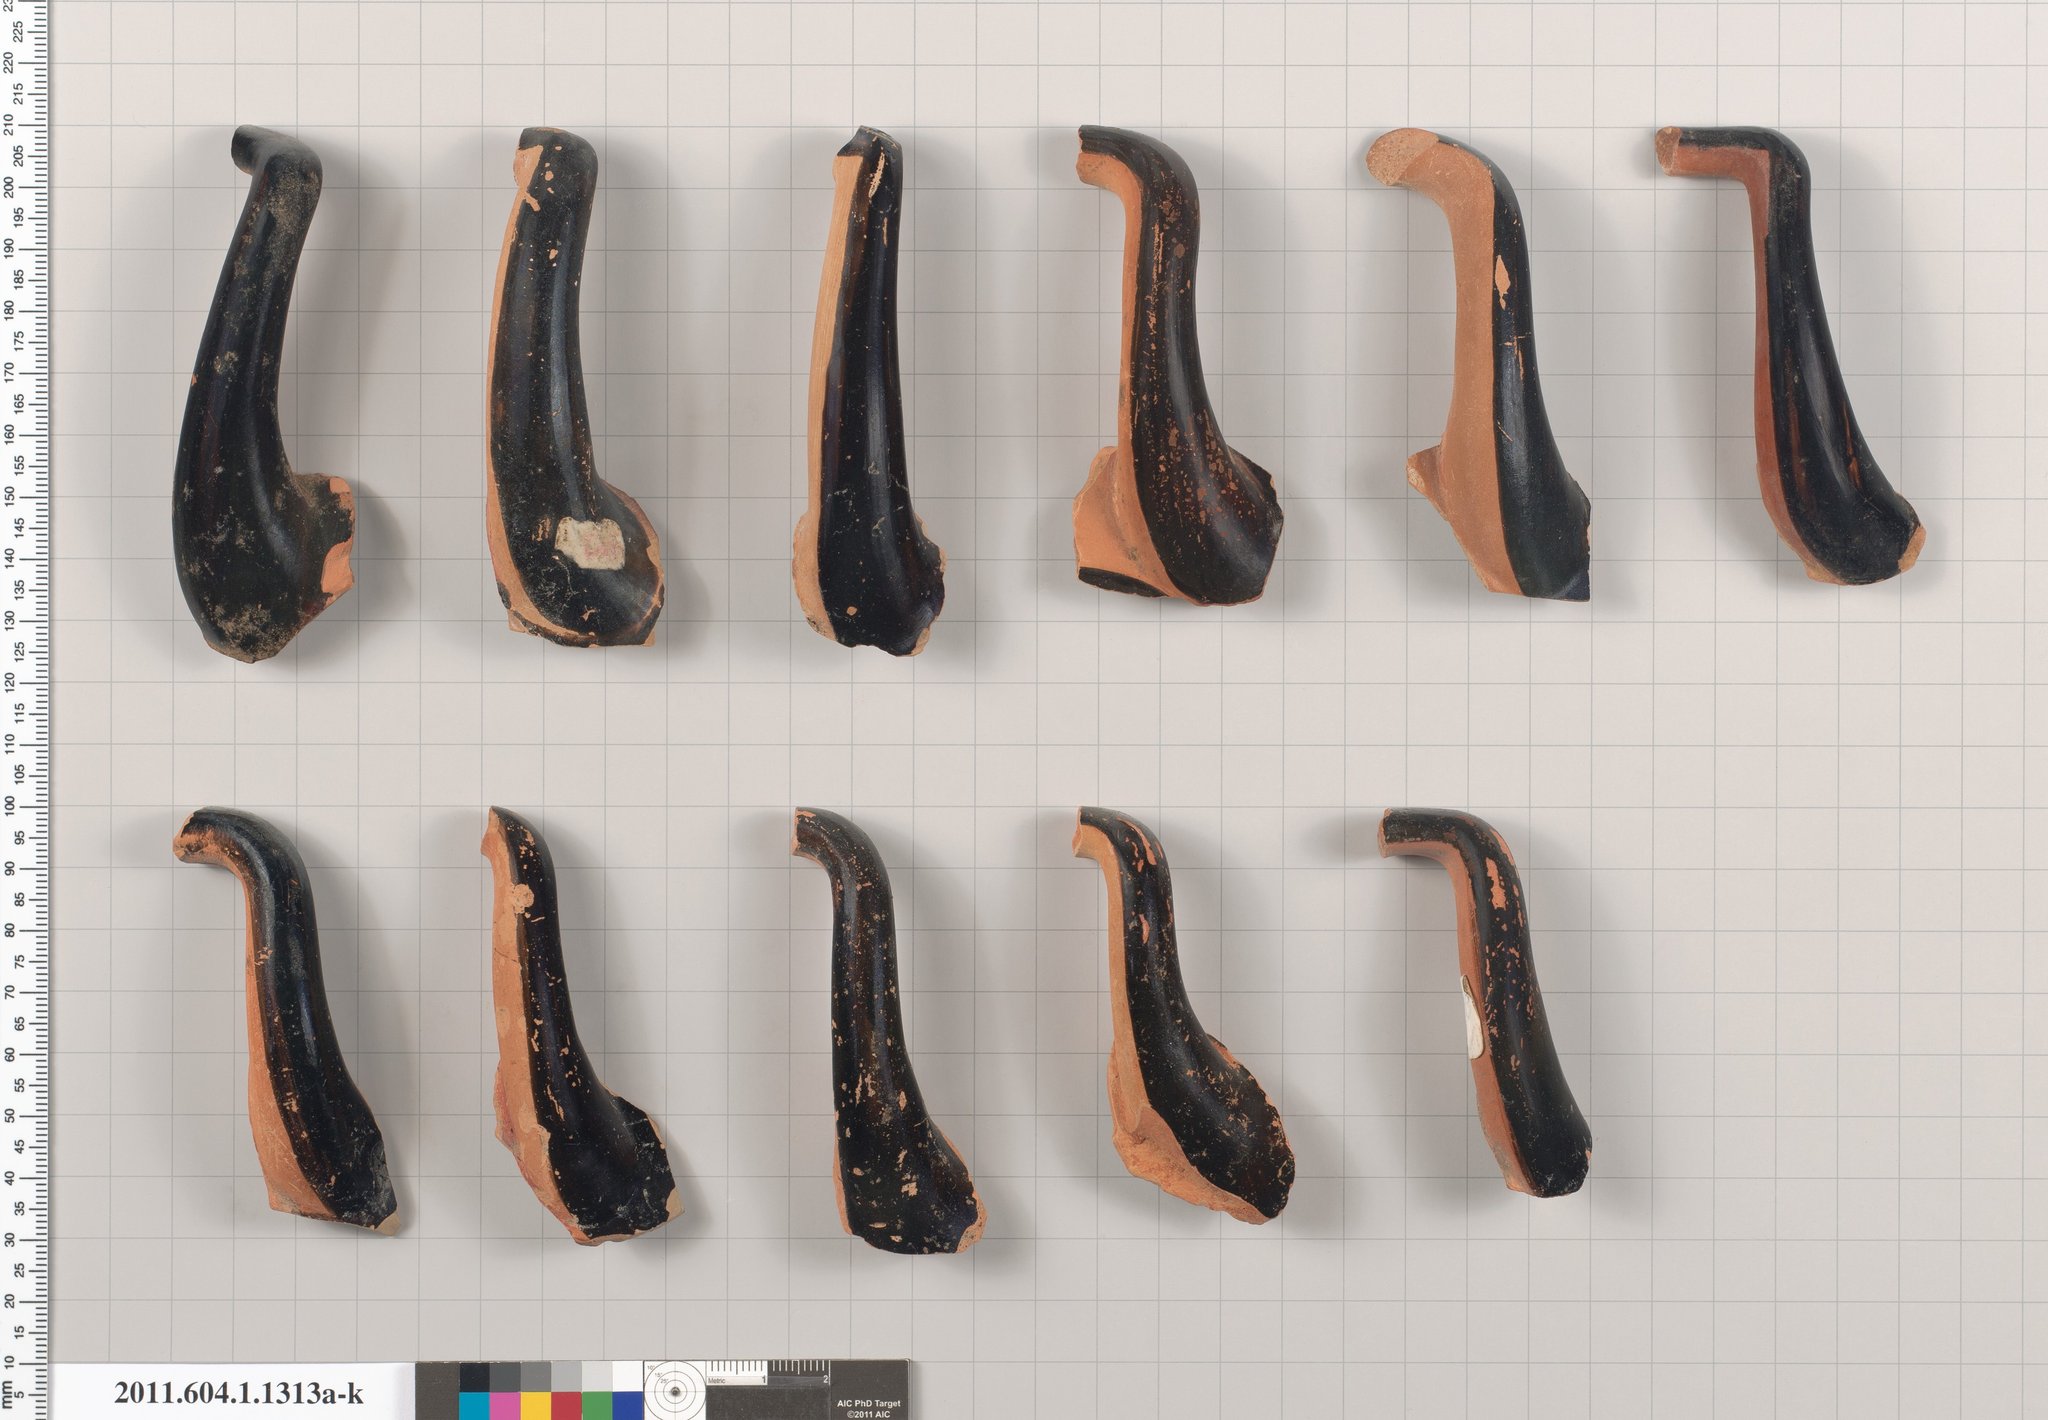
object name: kylix fragment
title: Terracotta fragments of kylikes (drinking cups)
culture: greek, attic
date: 500-401 BCE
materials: terracotta